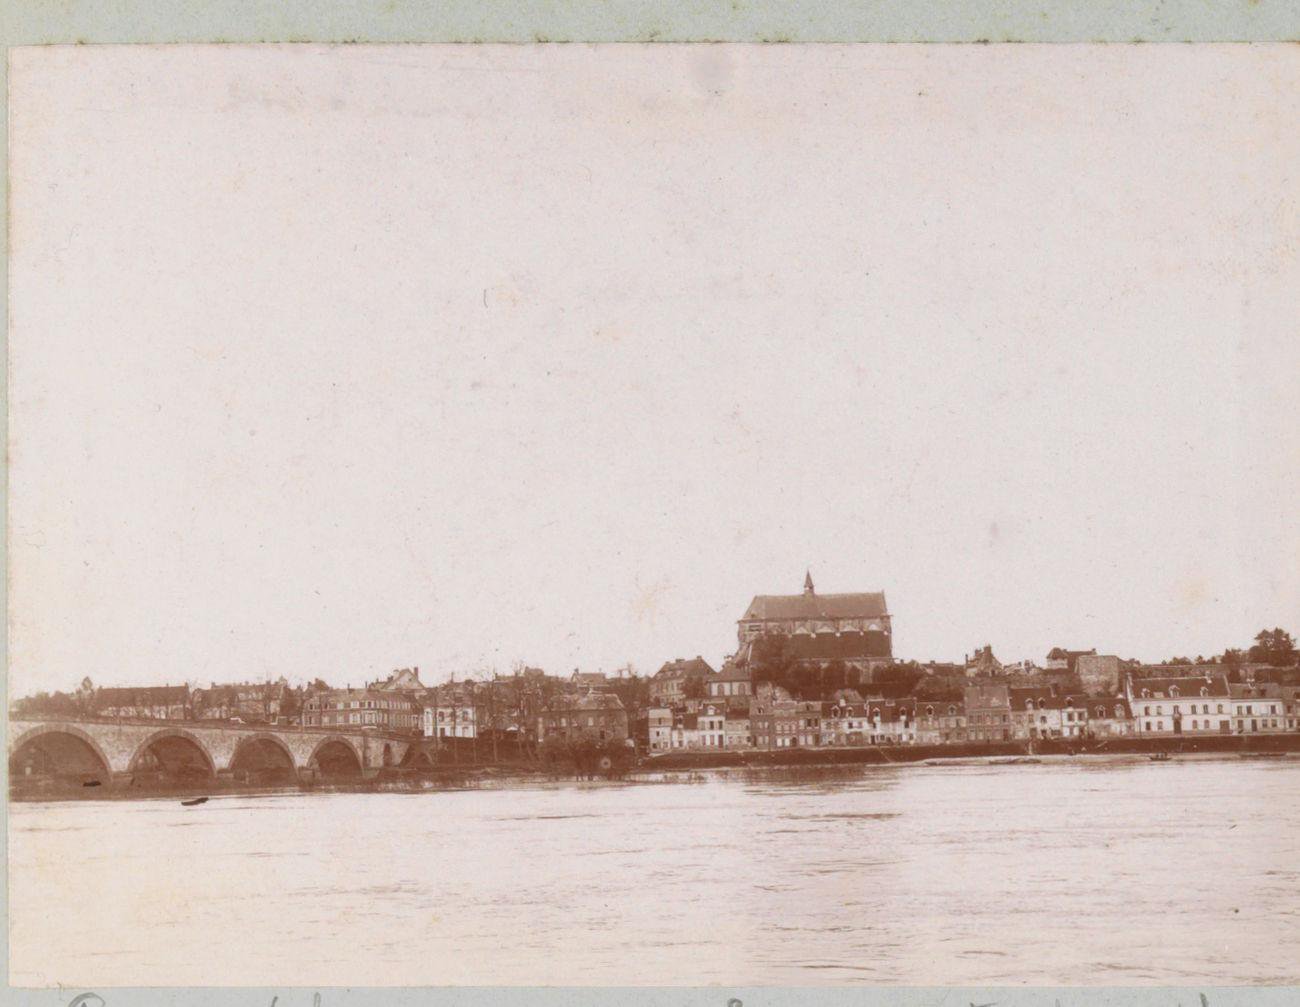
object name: photograph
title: Gezicht op Pont de l'Arche met links de brug en aan de horizon de Église St-Vigor (Notre-Dame des Arts)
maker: delizy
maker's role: manufacturer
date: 1897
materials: paper, photographic support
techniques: gelatin silver print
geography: pont-de-l'arche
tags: river, church (exterior), bridge in city across river, canal, etc., prospect of city, town panorama, silhouette of city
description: Onderdeel van Fotoalbum van een Franse amateurfotograaf met opnames van uitstapjes in Frankrijk, Spanje, België, Luxemburg en Nederland, de eerste automobielen en autoraces.